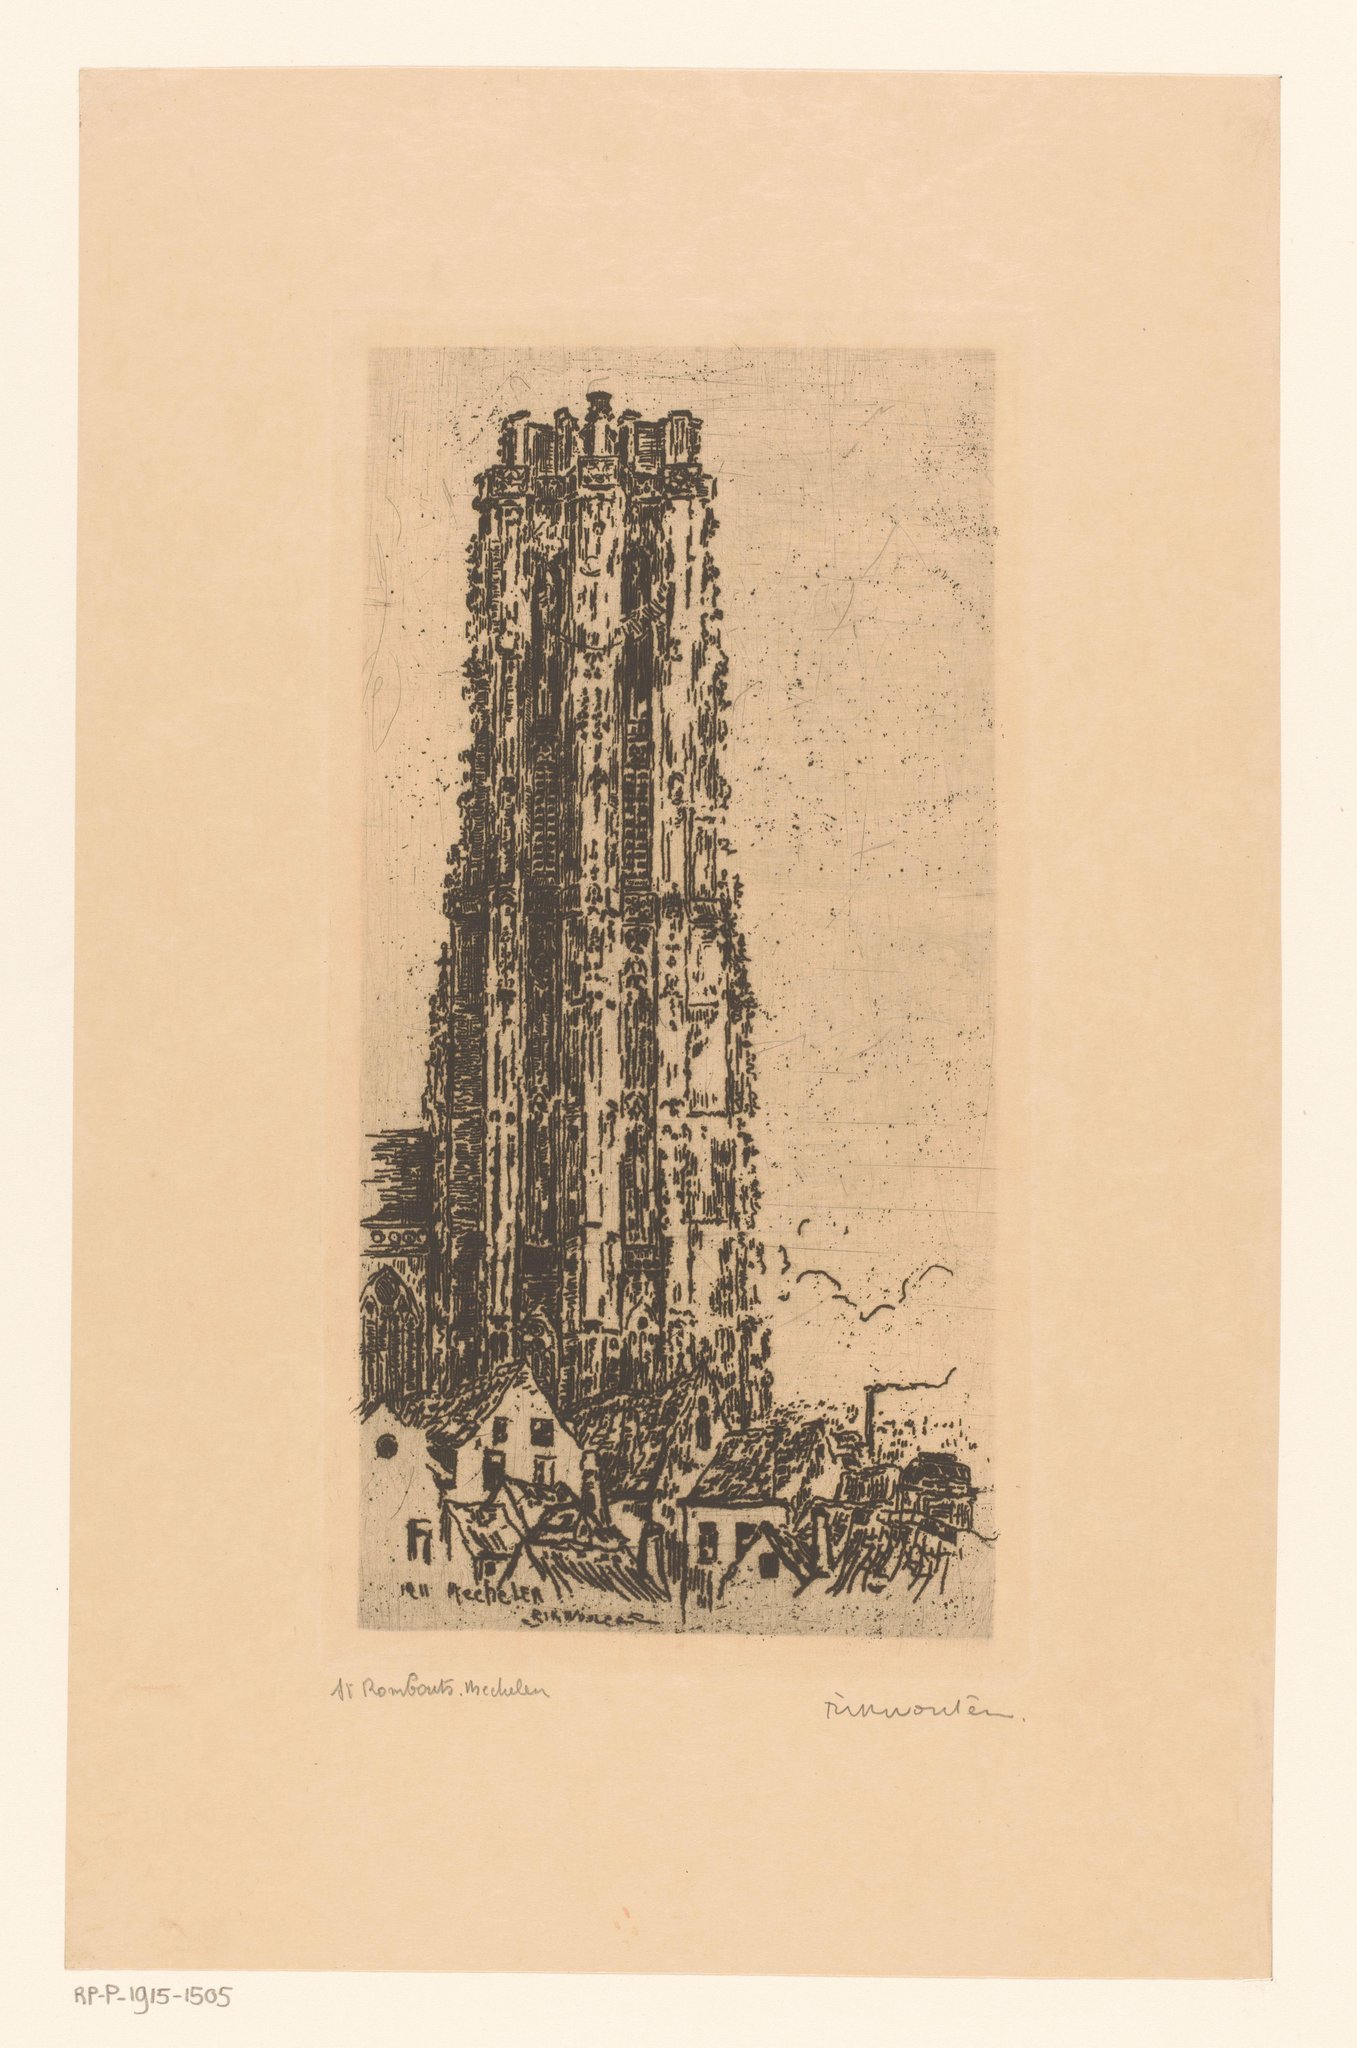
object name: print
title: Gezicht op de Sint-Romboutskathedraal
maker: rik wouters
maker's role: draughtsman, print maker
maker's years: 1882-1916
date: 1911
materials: paper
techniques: etching, intaglio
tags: city-view in general; 'veduta', parts of church exterior and annexes: tower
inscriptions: collector's mark: Lugt 2233